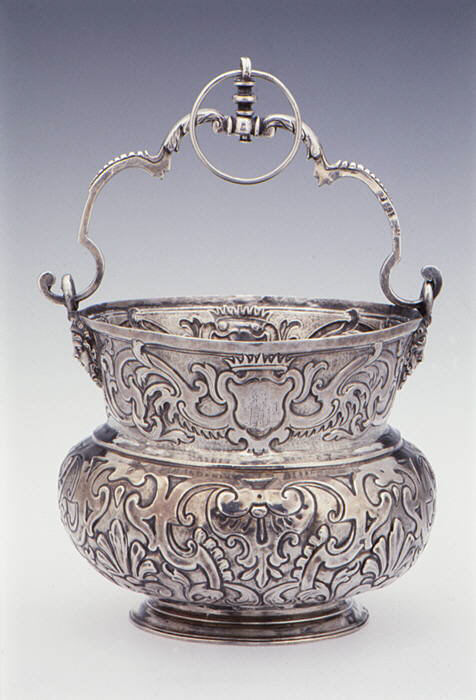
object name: bucket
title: Liturgical bucket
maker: giuseppe palmentiero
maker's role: maker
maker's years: 1650-1750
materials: silver